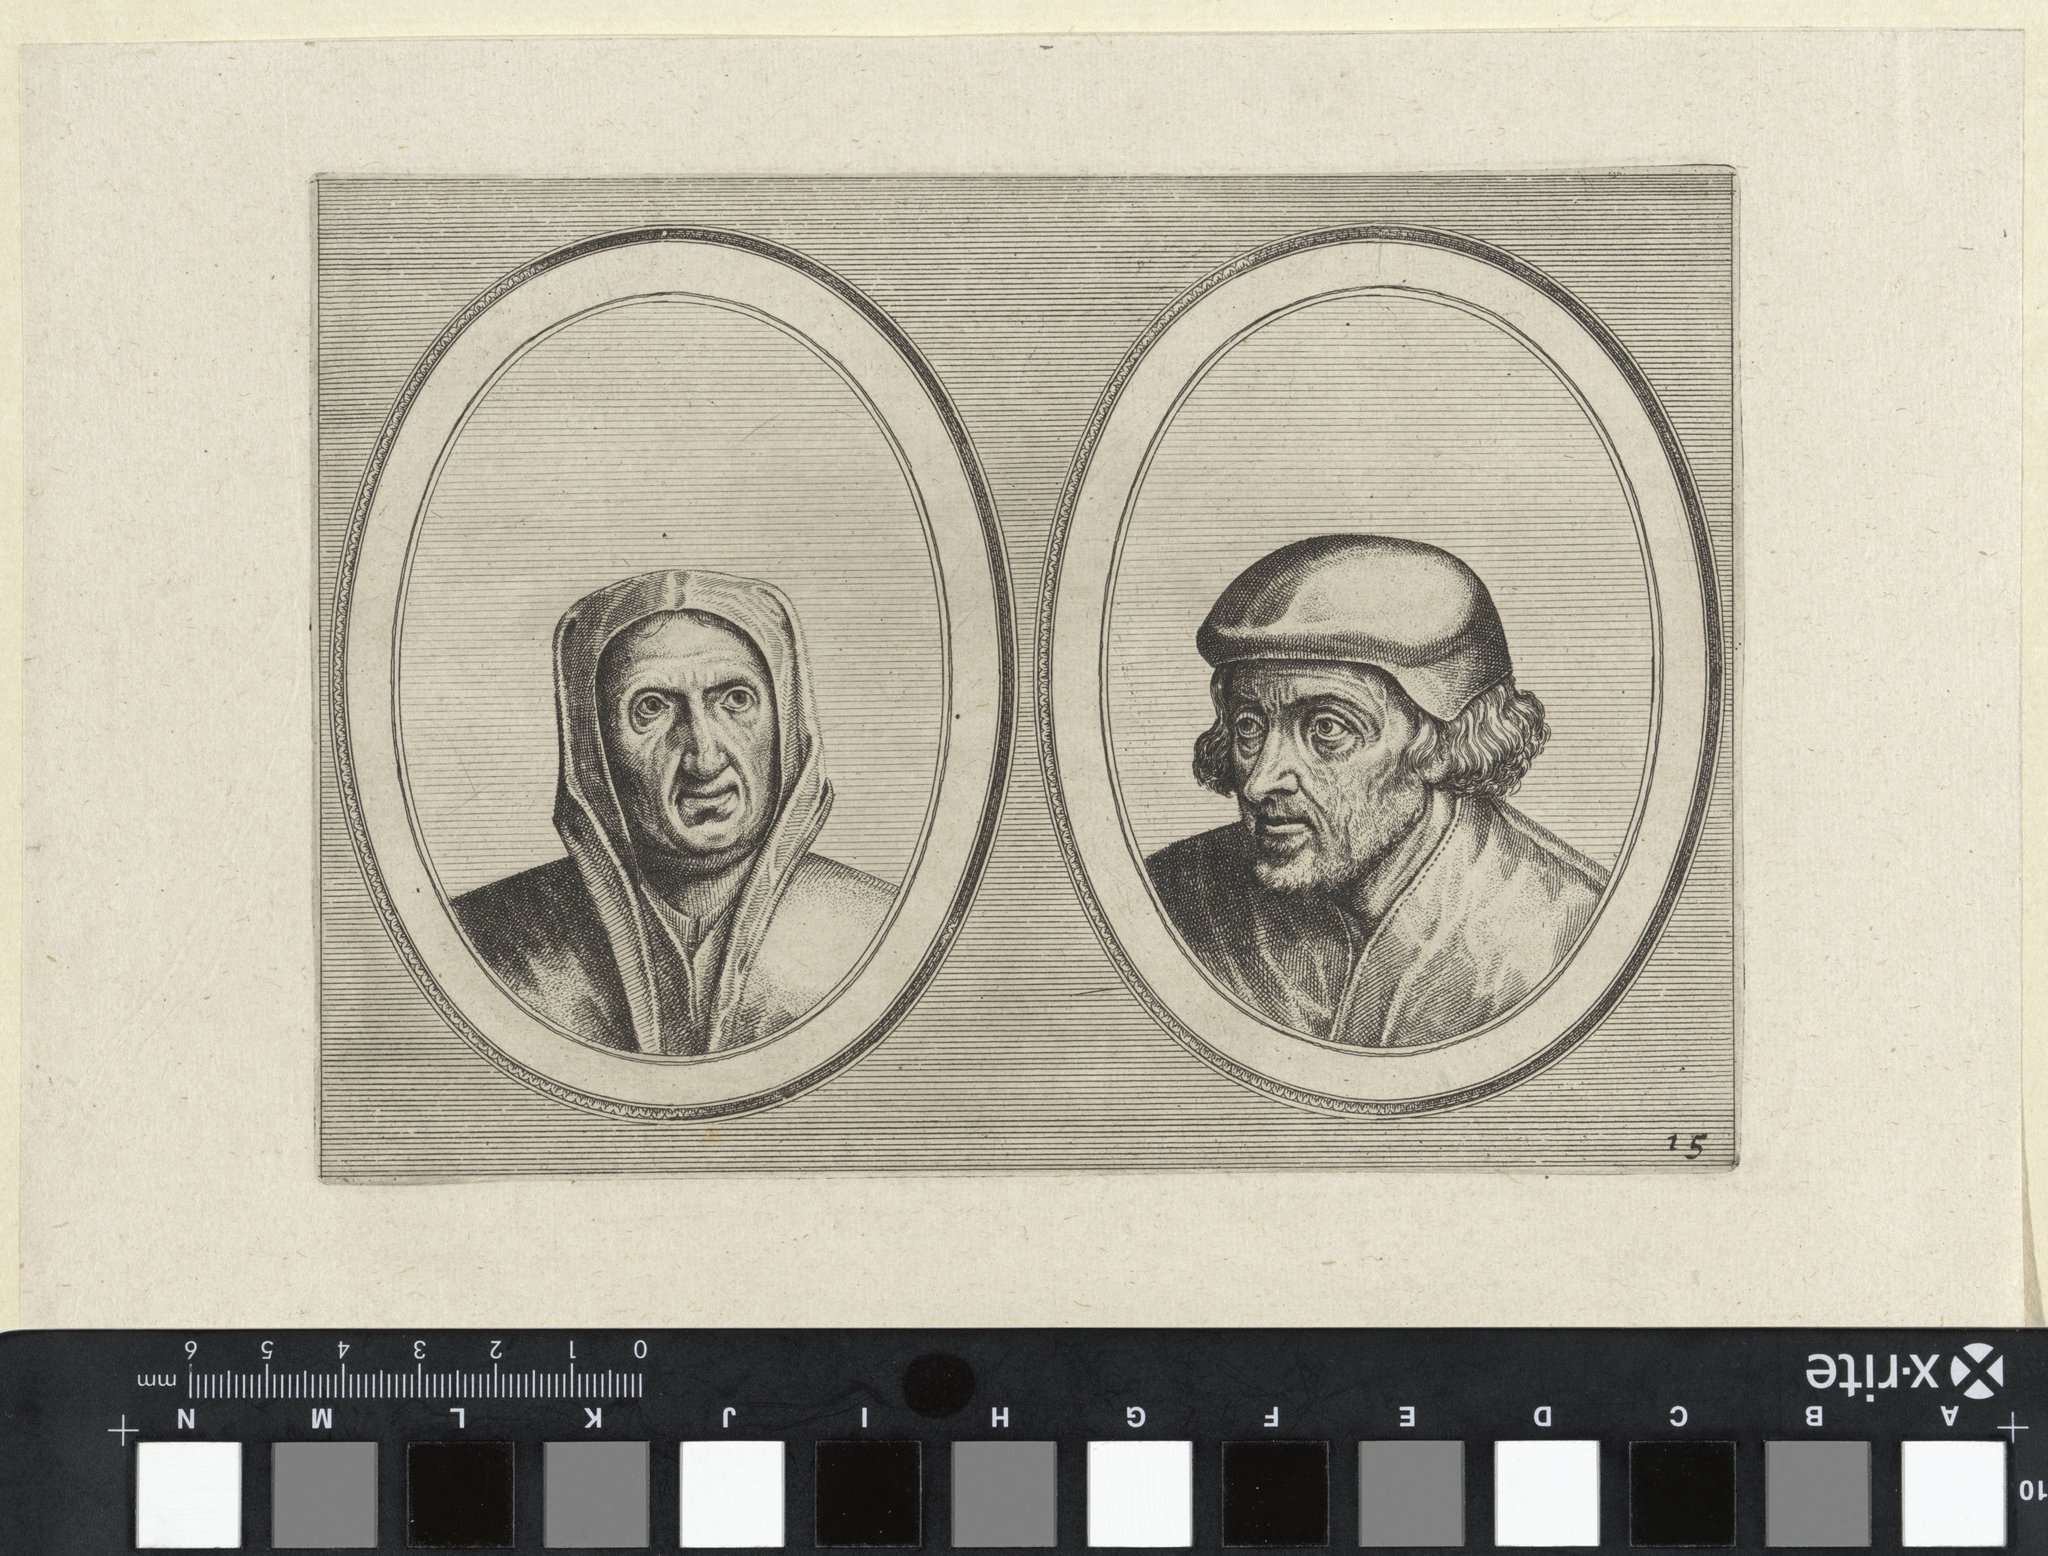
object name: print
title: Boerenkoppen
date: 1612-1652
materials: paper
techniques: engraving, etching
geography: amsterdam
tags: head-gear, farmers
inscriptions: collector's mark: Lugt 700, collector's mark: Lugt 240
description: Prent uit een serie van 36 prenten met koppen van boeren en boerinnen.